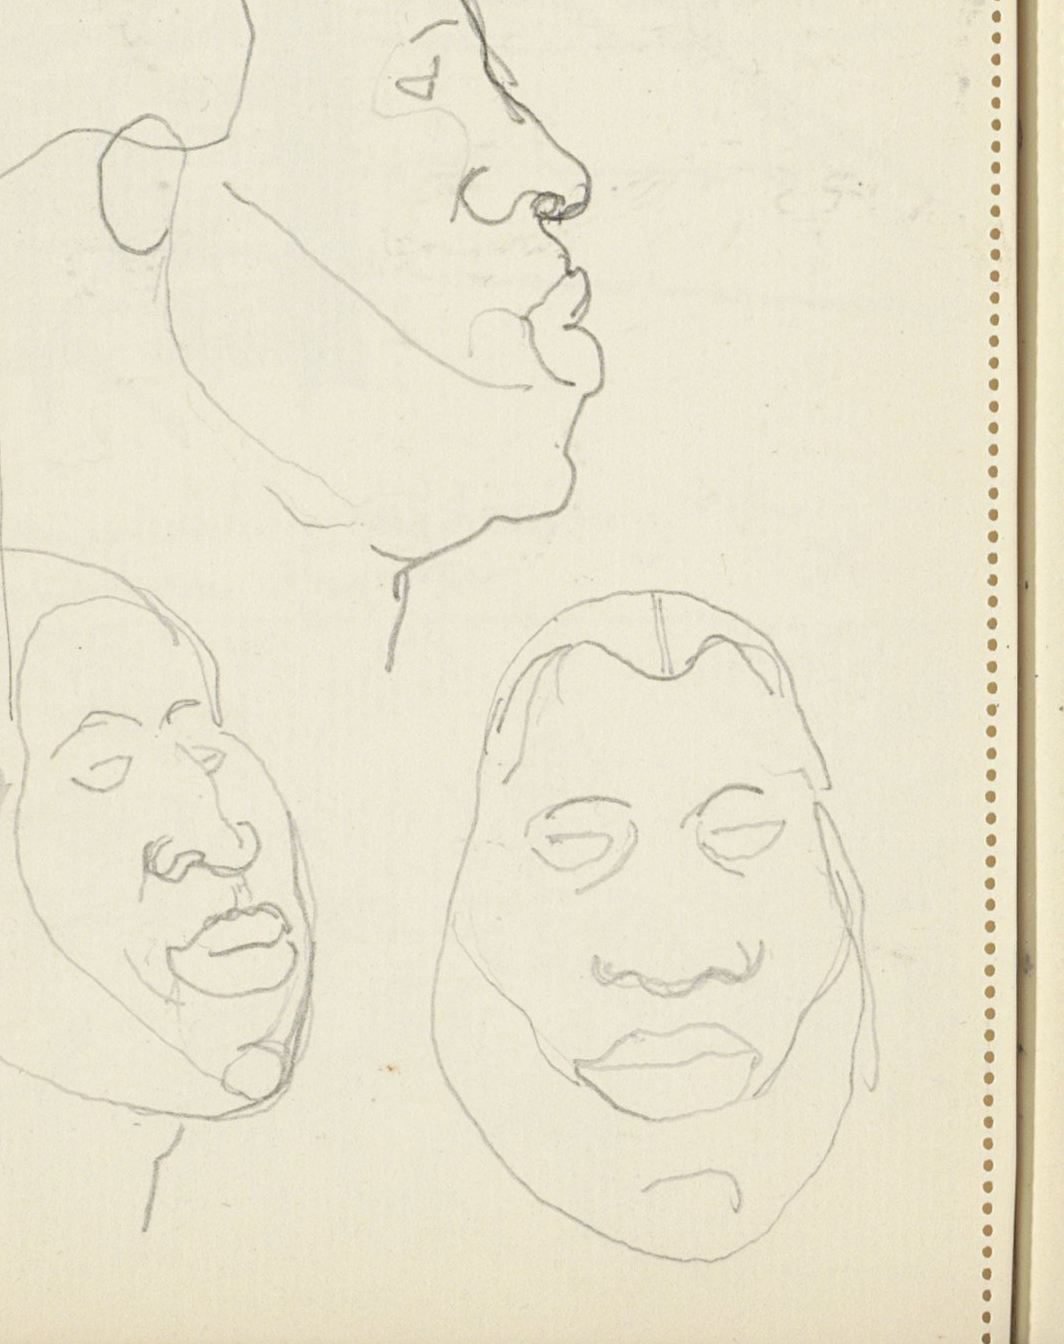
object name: sketchbook leaf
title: Hoofden van drie Afrikaanse mannen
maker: reijer stolk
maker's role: draughtsman, print maker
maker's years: 1896-1945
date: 1916-1945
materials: paper, pencil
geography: africa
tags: head (human), africans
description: Blad 39 verso uit een schetsboek met 60 bladen.